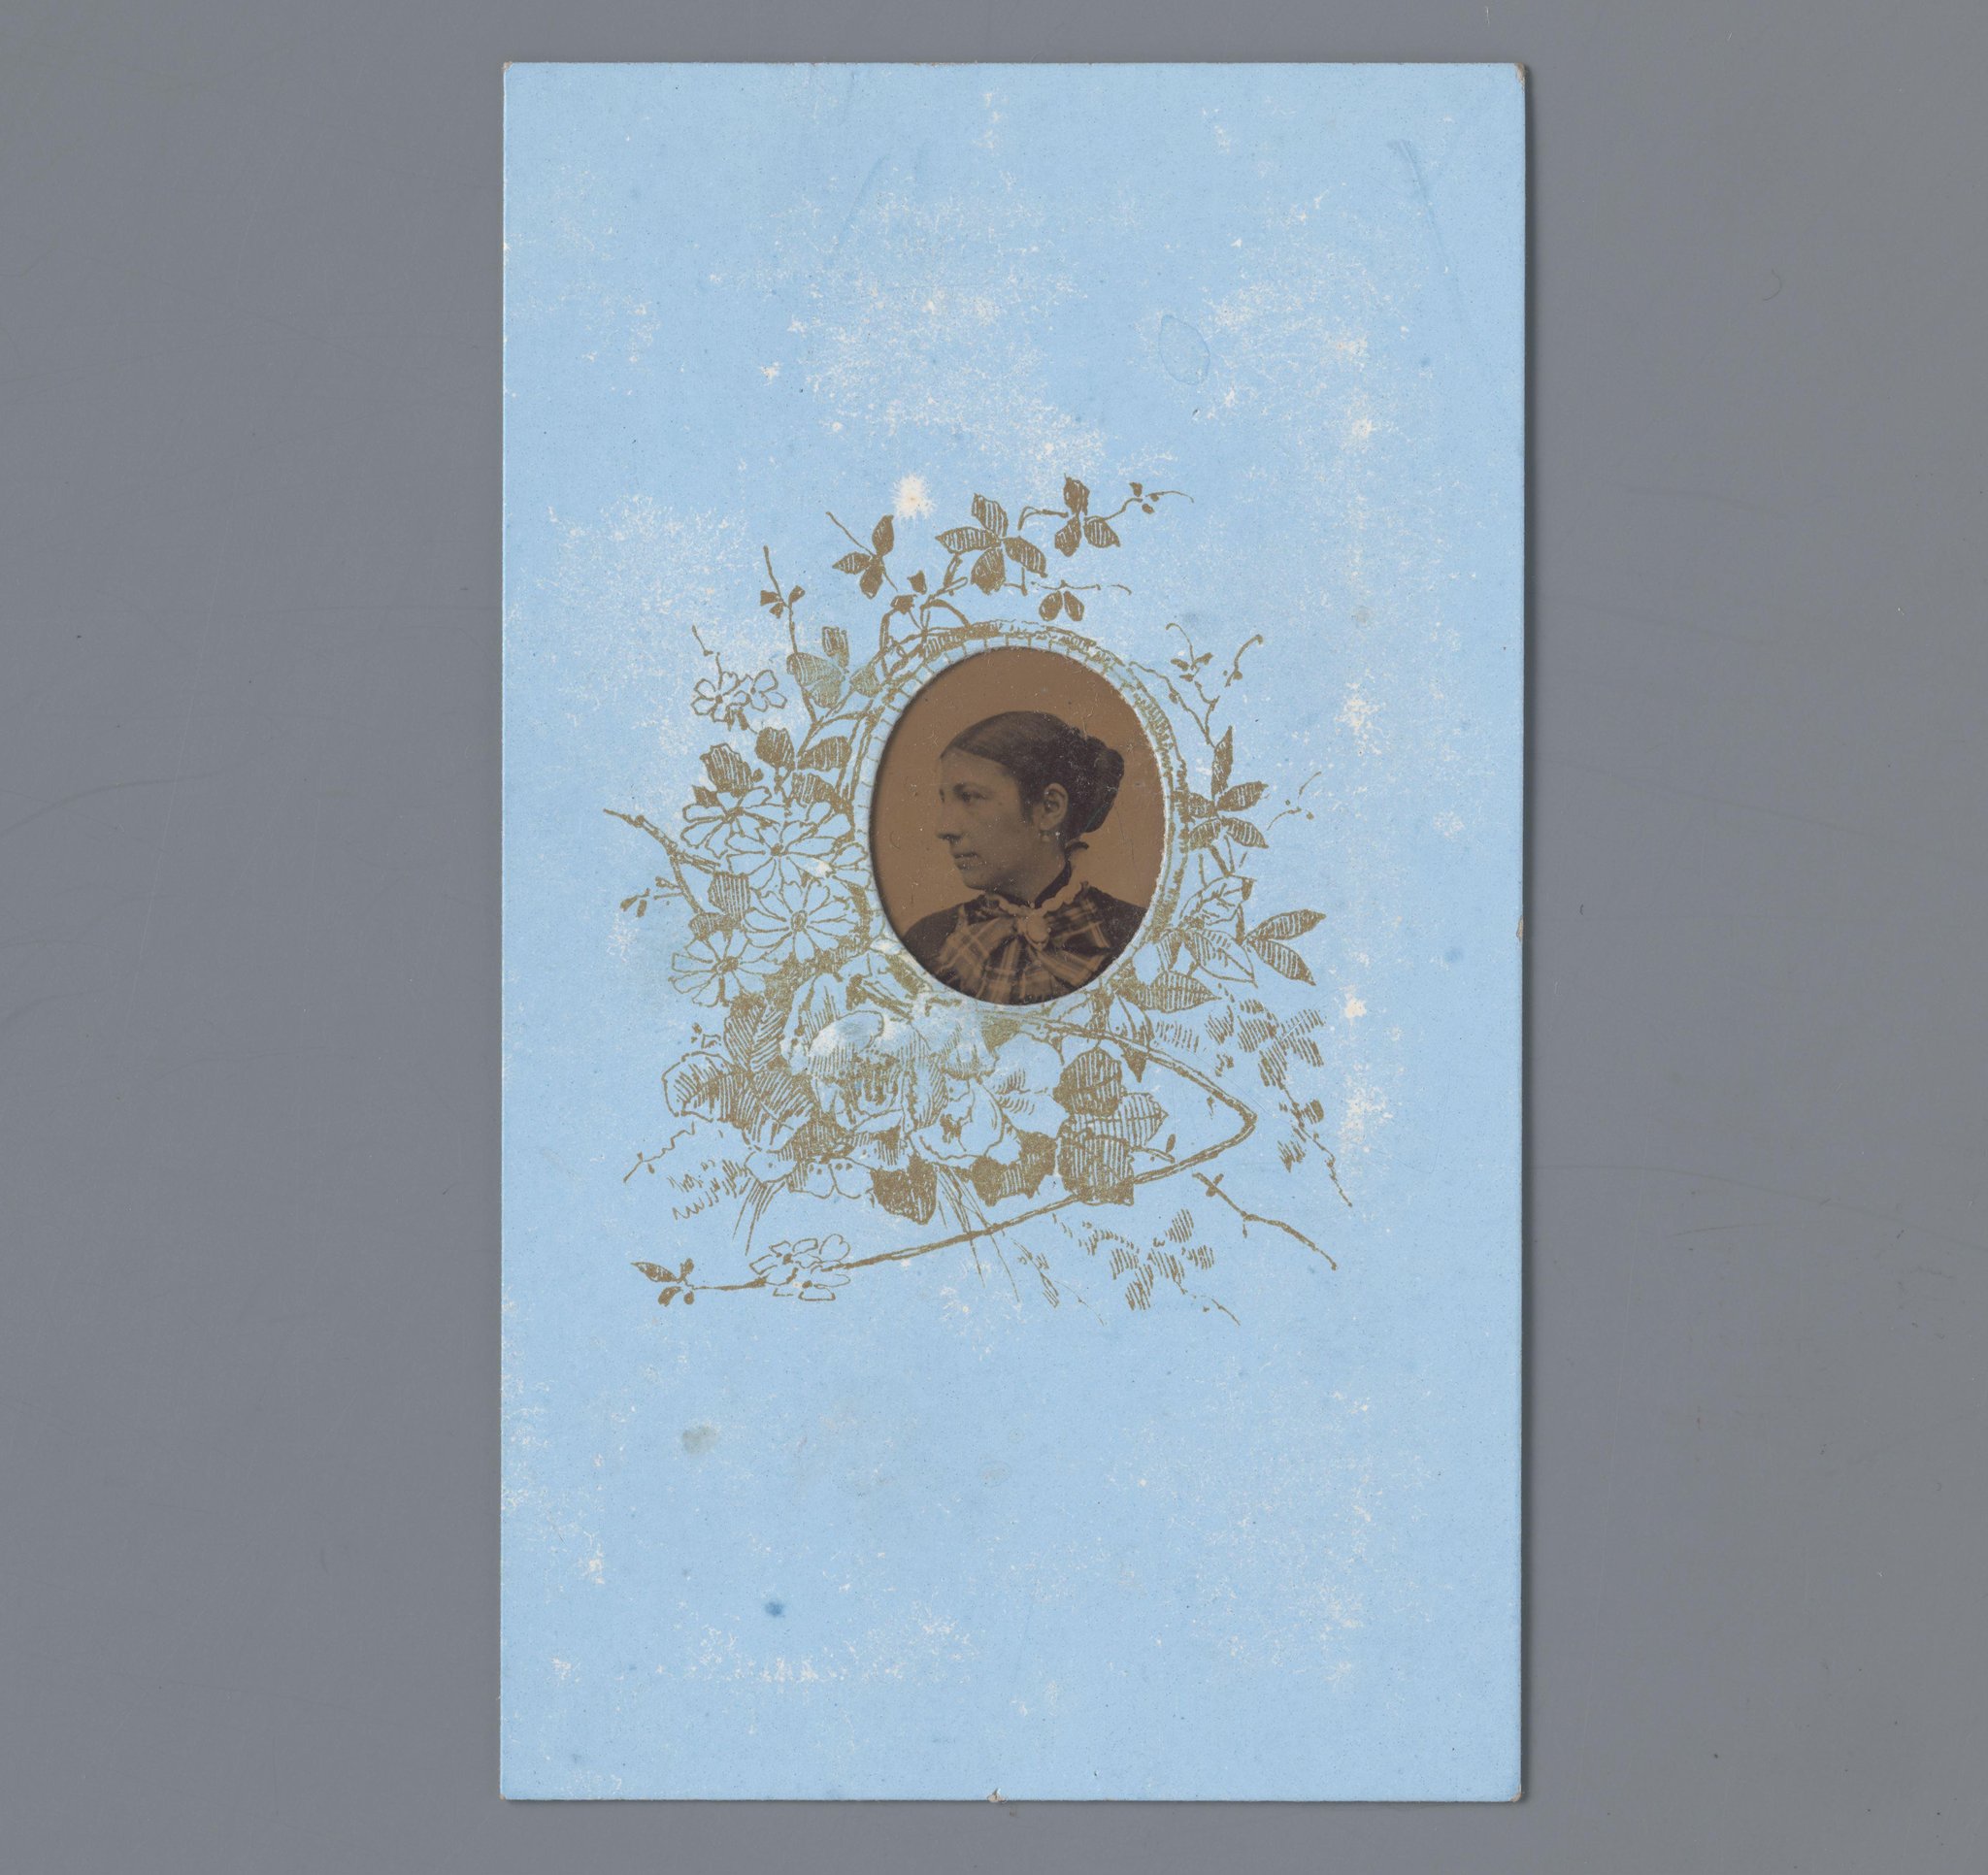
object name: photograph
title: Portret van een onbekende vrouw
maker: Anonymous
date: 1855-1900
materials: cardboard, iron, paper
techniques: ferrotyping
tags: historical persons - bb - woman